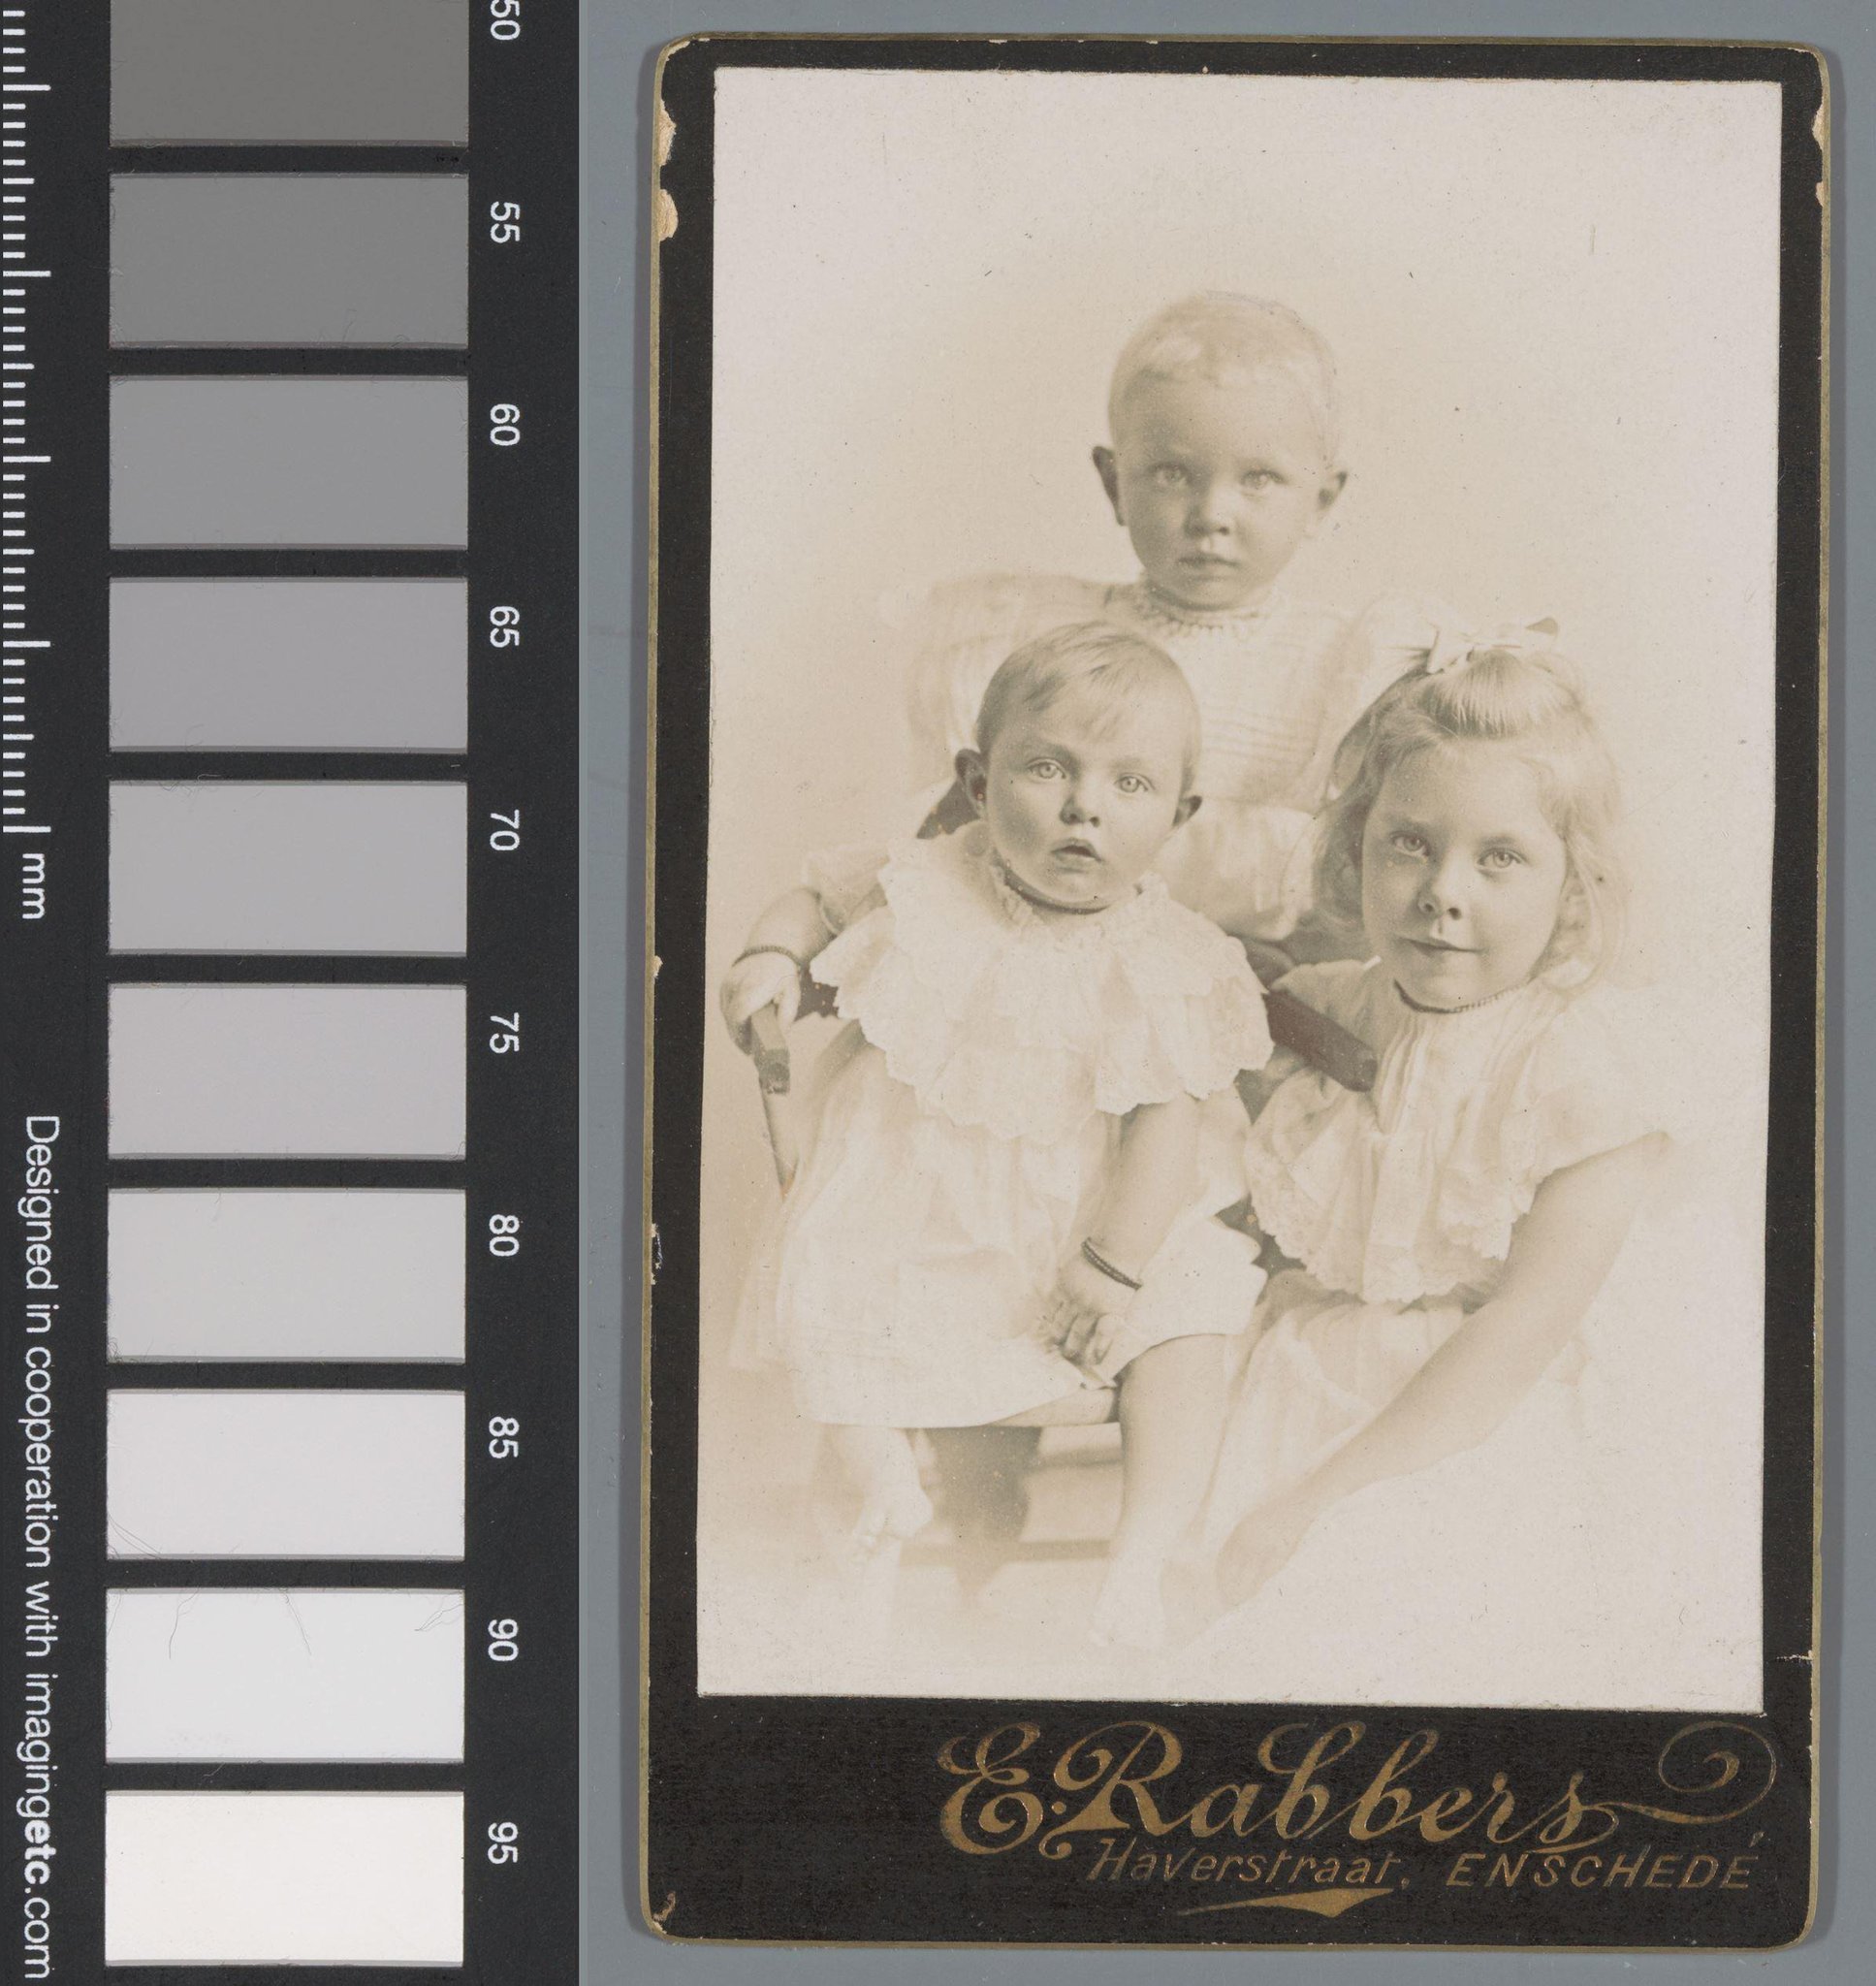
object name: photograph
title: Portret van drie onbekende kinderen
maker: evert rabbers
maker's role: fotograaf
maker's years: 1875-1967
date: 1897-1920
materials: cardboard, photographic support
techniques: gelatin silver print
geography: enschede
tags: historical persons, child (+ three persons)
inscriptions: address: ‘E. Rabbers/ Haverstraat. ENSCHEDÉ’